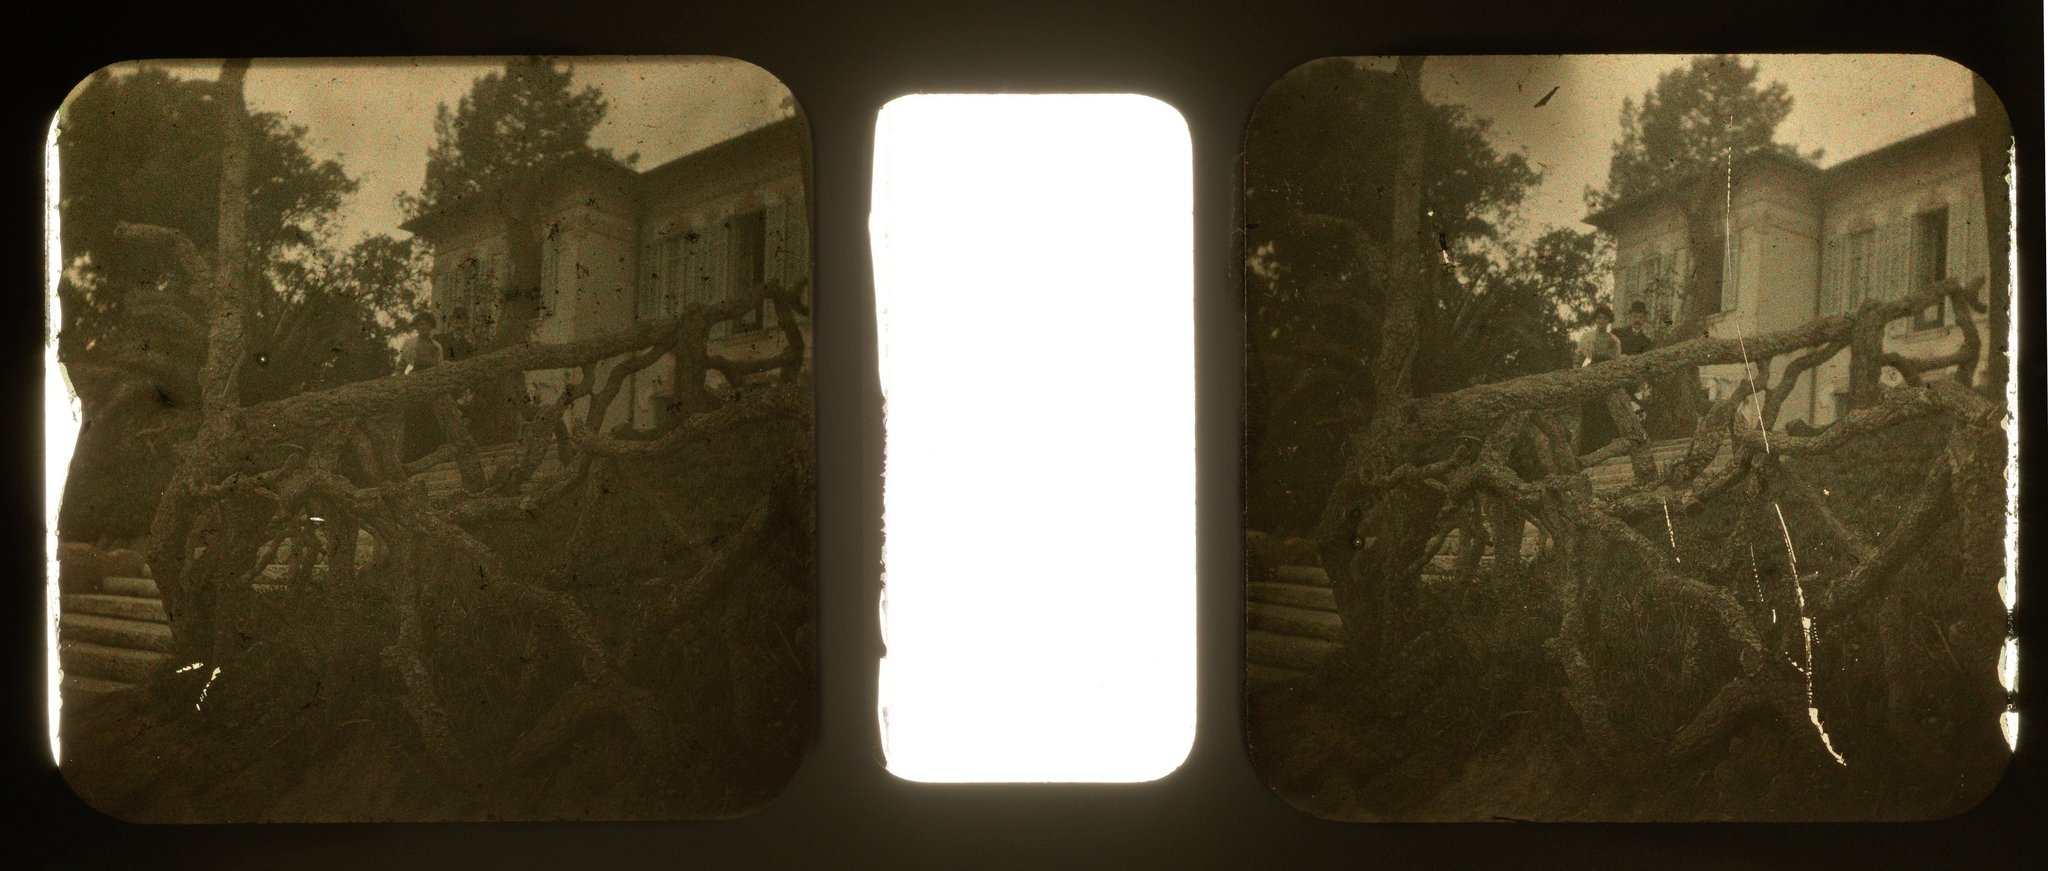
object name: stereoscopic photograph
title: Man en vrouw op de trap voor een landhuis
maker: adolphe burdet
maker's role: fotograaf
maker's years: 1860-1940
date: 1907-1935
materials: glass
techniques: autochrome process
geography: france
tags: country-house, france